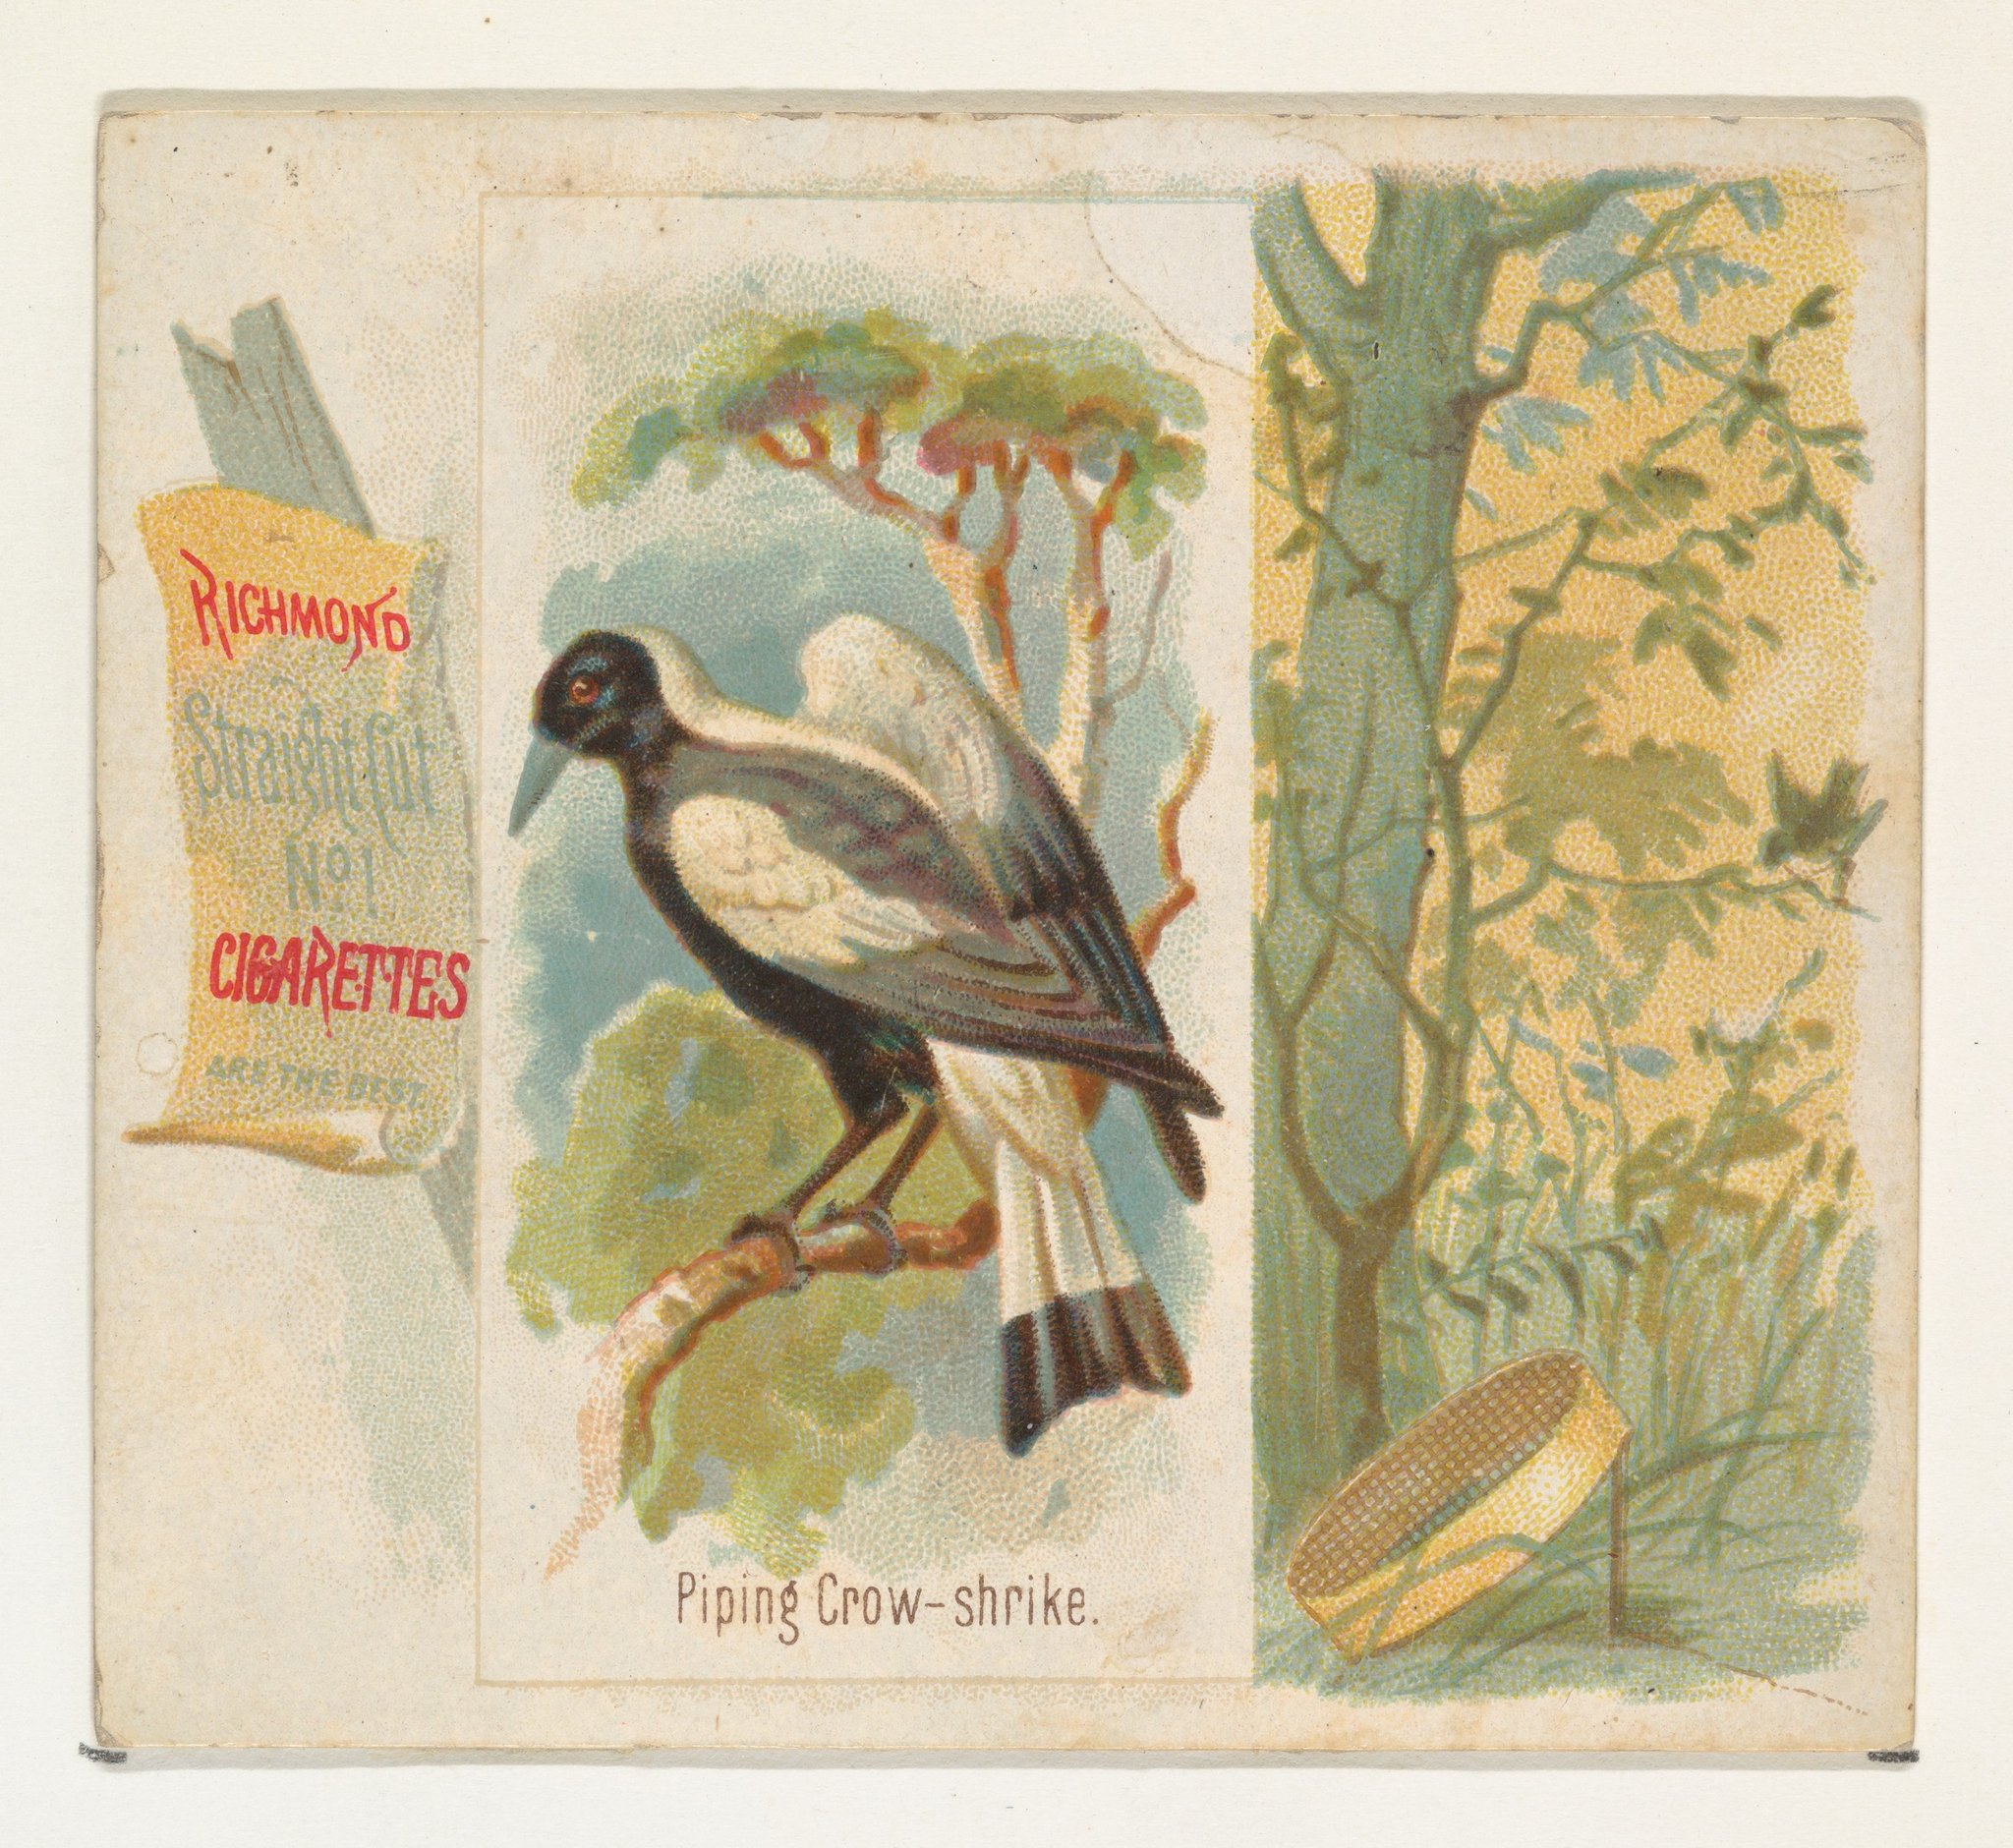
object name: print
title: Piping Crow-shrike, from the Song Birds of the World series (N42) for Allen & Ginter Cigarettes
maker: allen & ginter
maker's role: publisher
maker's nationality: american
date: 1890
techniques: color lithograph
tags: birds